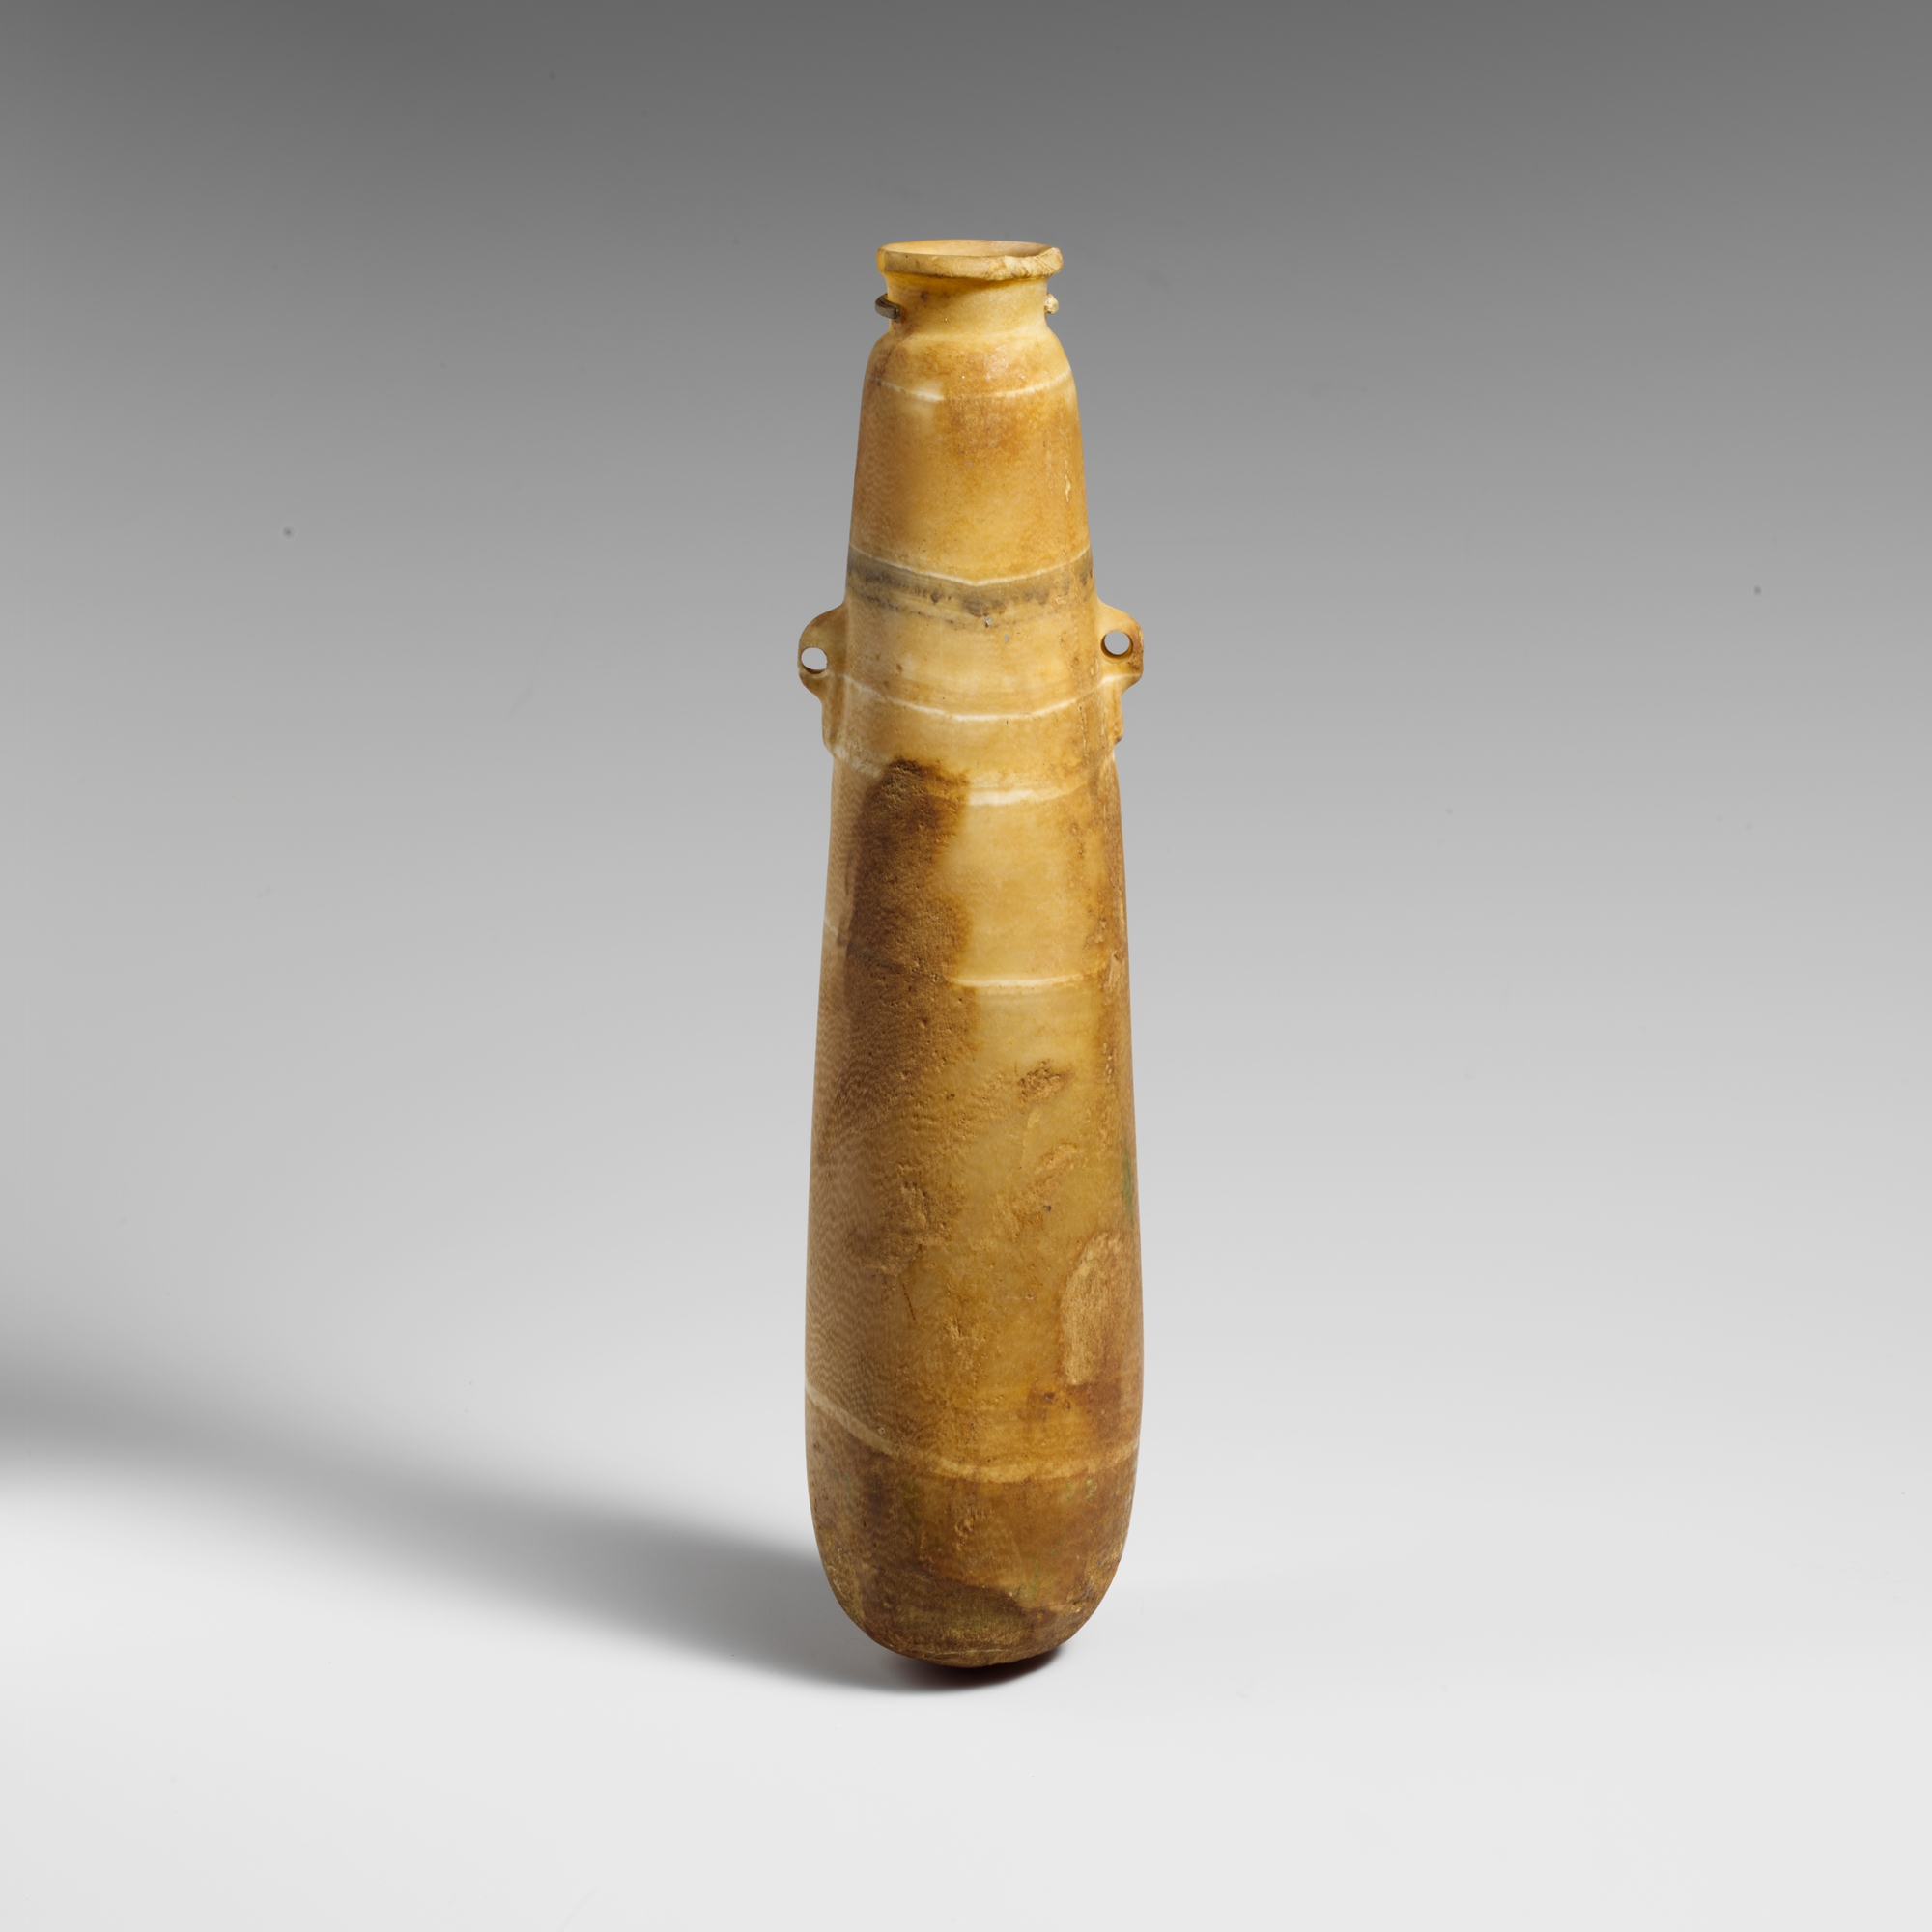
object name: alabastron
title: Alabaster alabastron (perfume vase)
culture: cypriot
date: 500-301 BCE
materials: alabaster